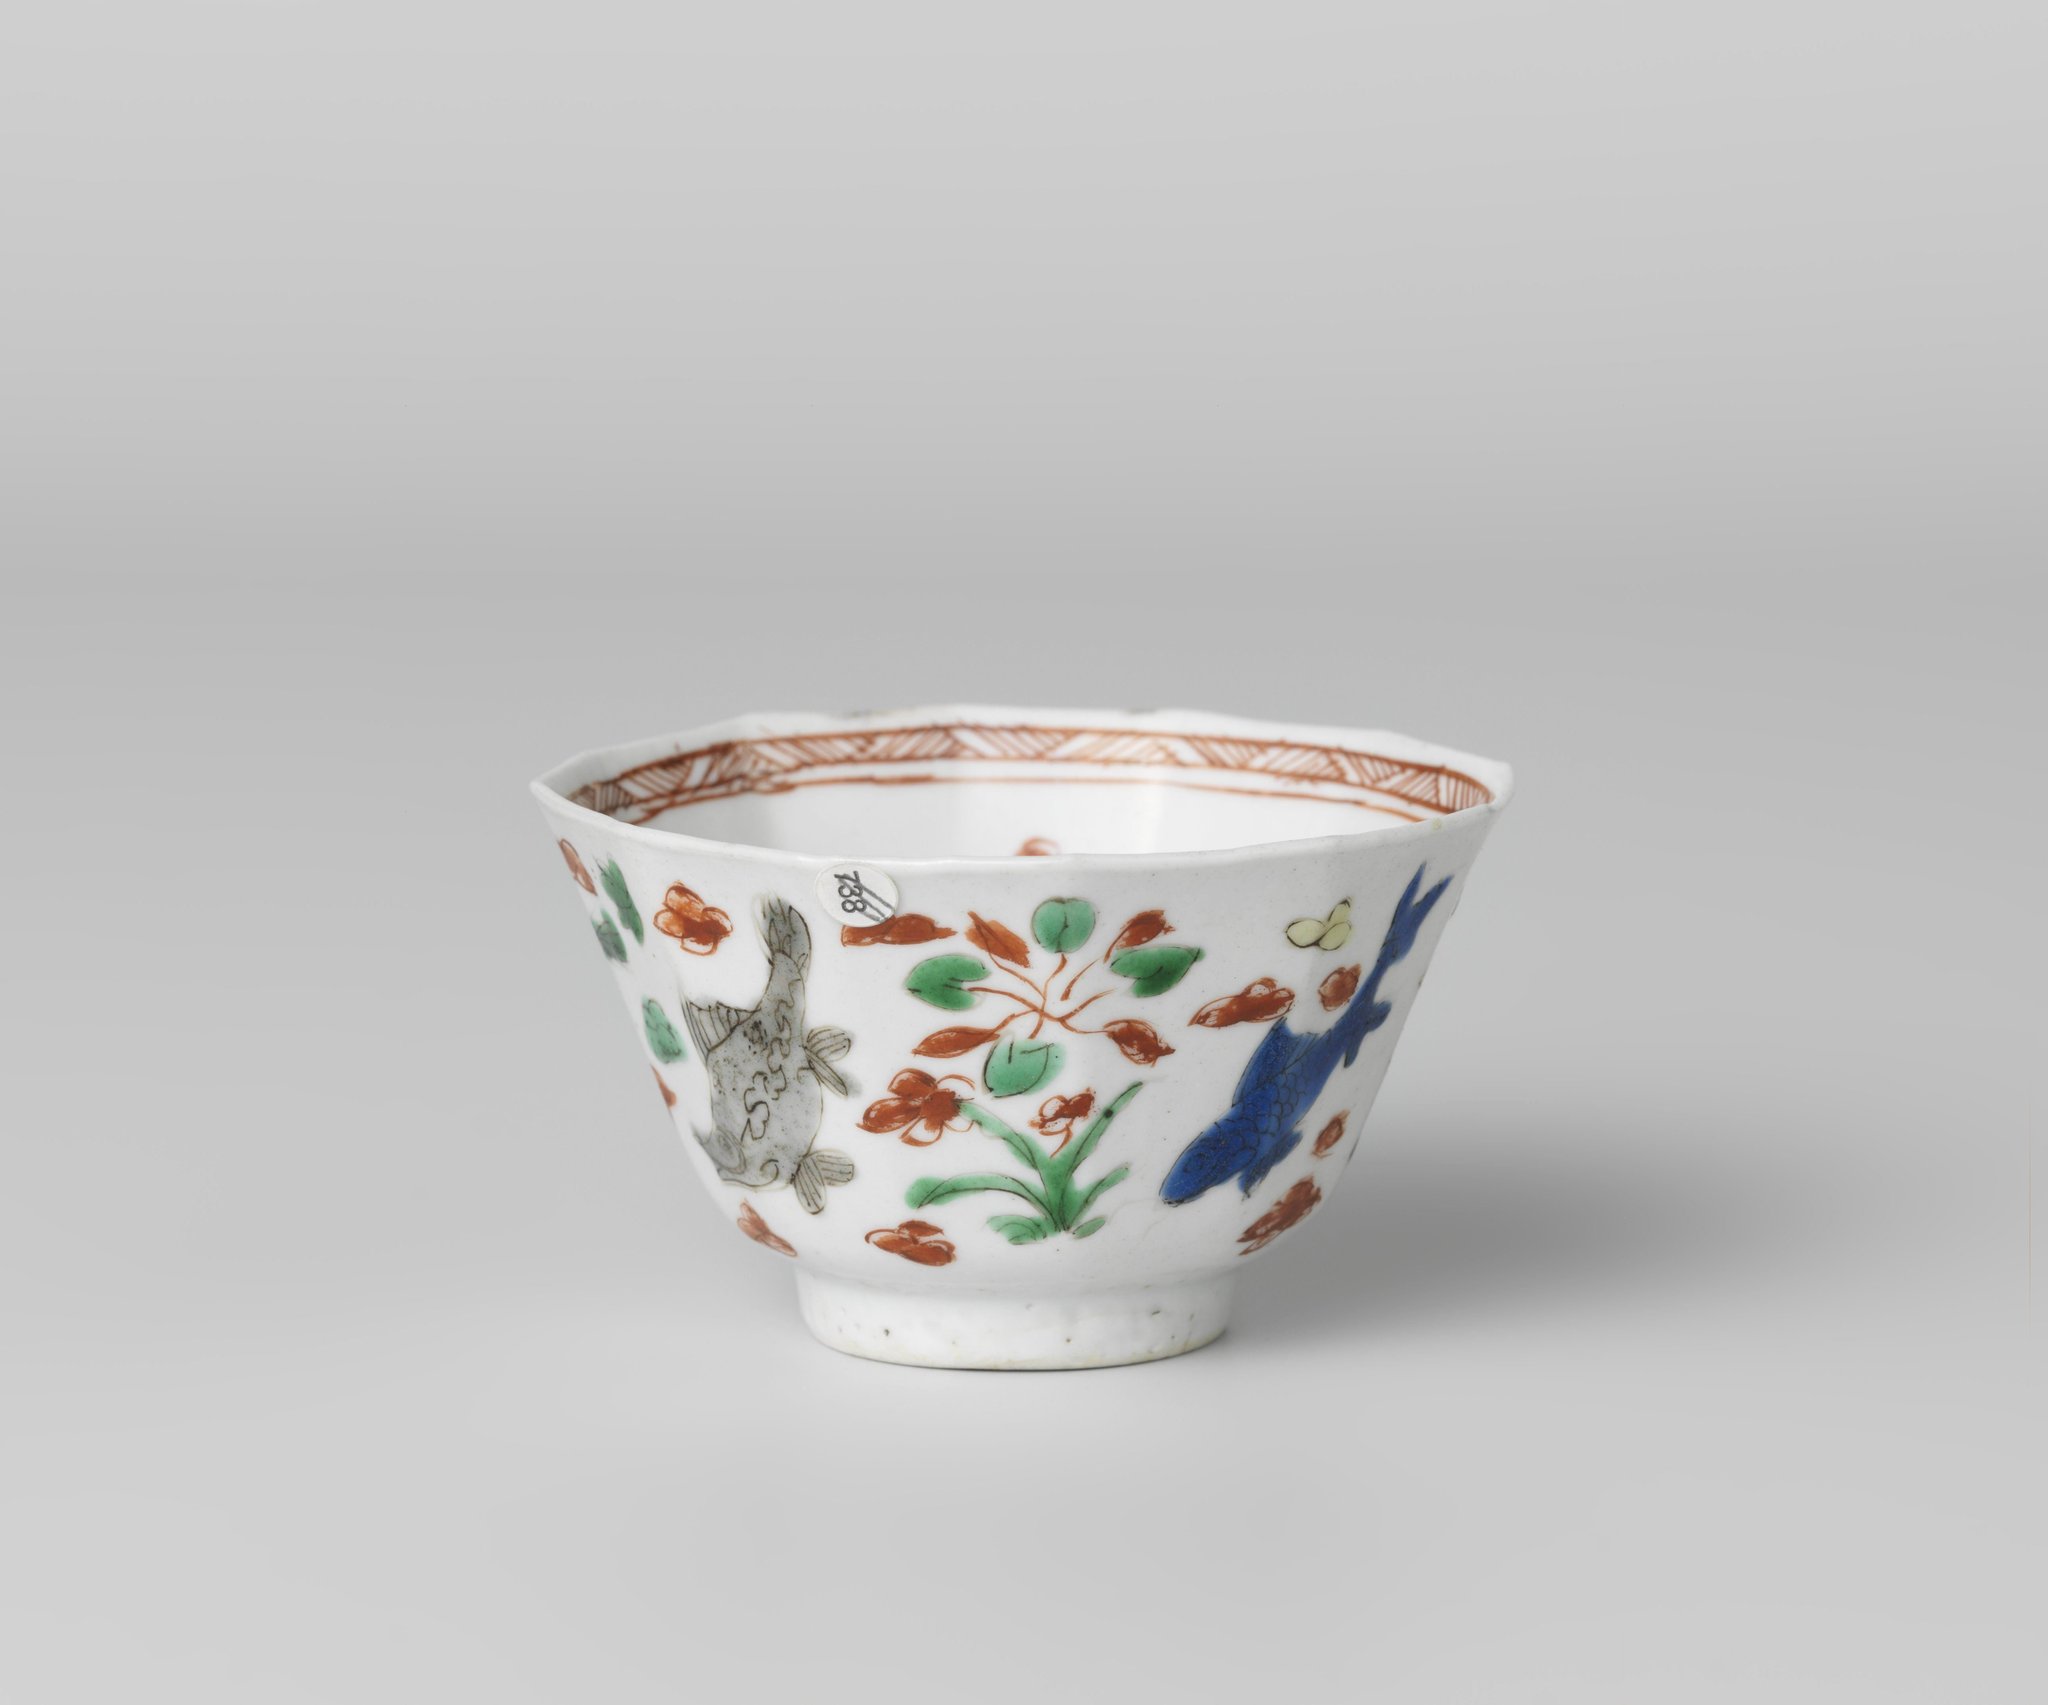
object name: cup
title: Twelve-sided cup with prawn, fish and water plants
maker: Anonymous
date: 1700-1724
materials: cobalt, glaze, paint, porcelain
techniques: firing, forming, turning, vitrification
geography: china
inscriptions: mark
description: Twaalfhoekige kop van porselein, versierd in onderglazuur blauw en op het glazuur blauw, rood, groen, geel, aubergine en zwart. Op de buitenzijde vier vissen en waterplanten; op de bodem een garnaal, de wand met vier planten in email, de rand met zigzag-werk. Gemerkt op de onderzijde met een paddenstoel (lingzhi) in een dubbele cirkel. Famille verte.